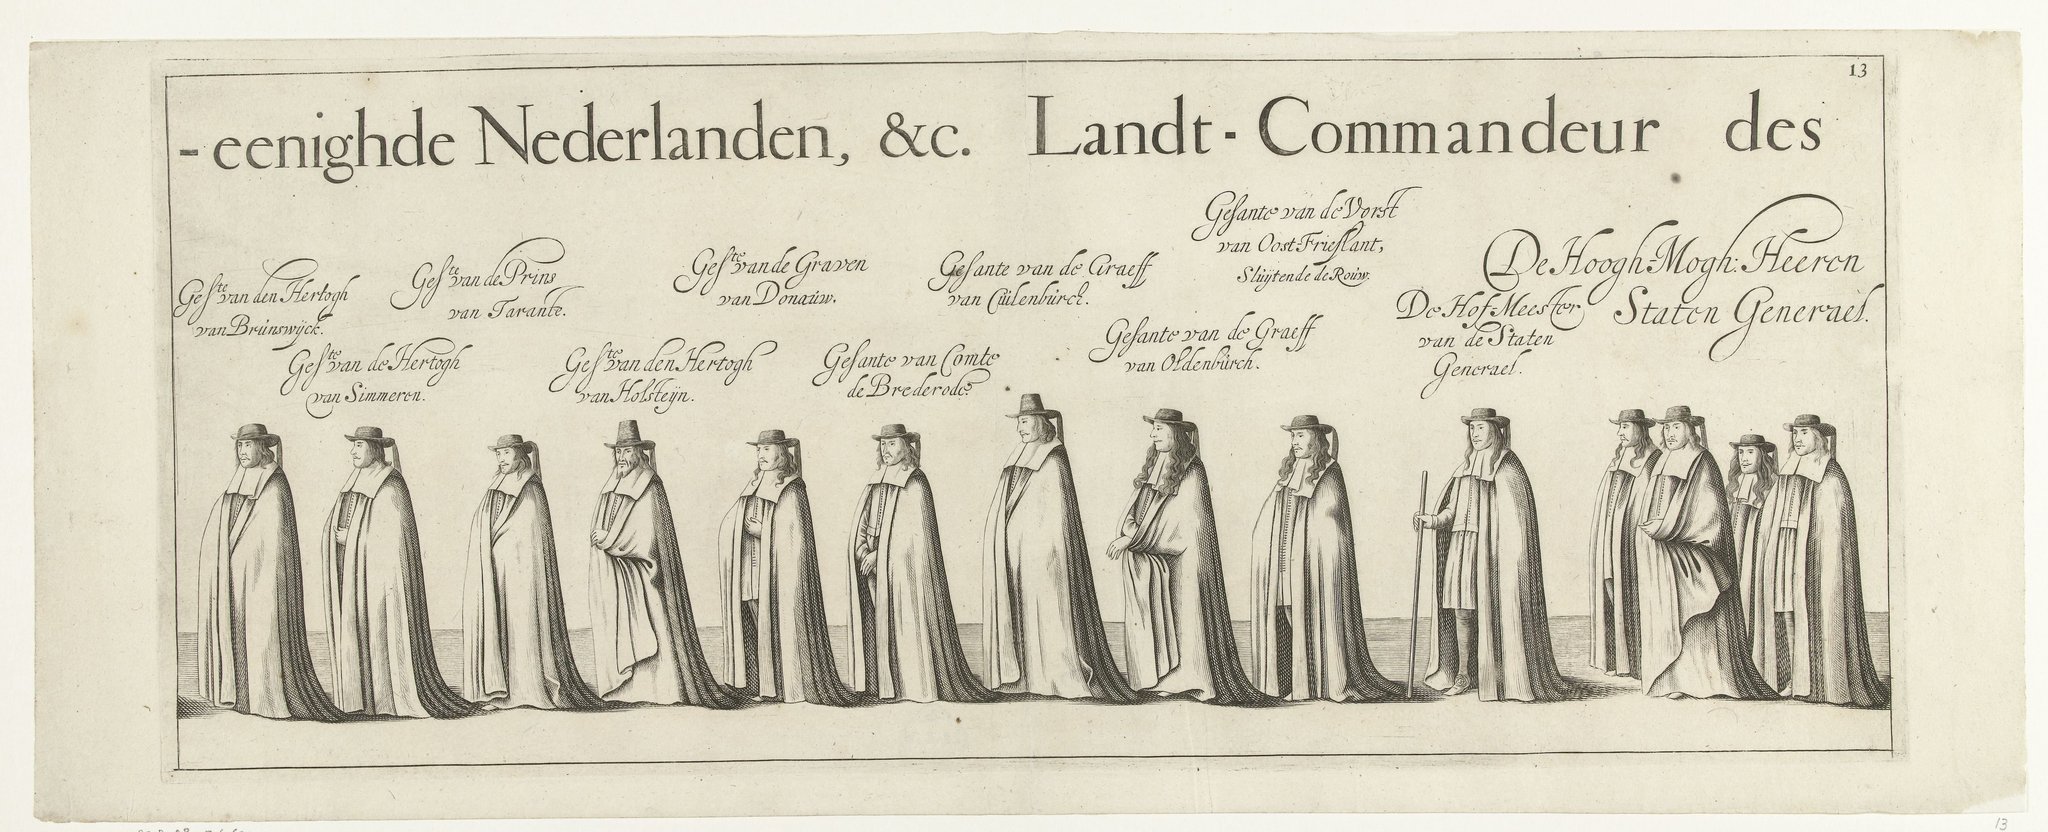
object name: print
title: Rouw-Staetelijcke Lijk-pracht in de Uyt-Vaert en Begraefenisse van het ont-zielde Lichaem van (...) Wilhelm Frederich (...) Overleden binnen Leeuwarden (...) den een-en-twintichsten October, MDCLXIV. en aldaer in 't Choor van de Jacobijner Kerck, den vyfthienden december MDCLXIV. Oude Stijl (...)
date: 1666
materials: paper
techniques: engraving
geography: leeuwarden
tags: arnhem, cortege, funeral procession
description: Begrafenisoptocht van Willem Frederik, graaf van Nassau-Dietz, in Leeuwarden op 6 januari 1665. Deel van de begrafenisstoet. Plaat nr. 13 in een ensemble van 25 ongemonteerde genummerde platen en twee tekstbladen die samen een lange fries vormen.